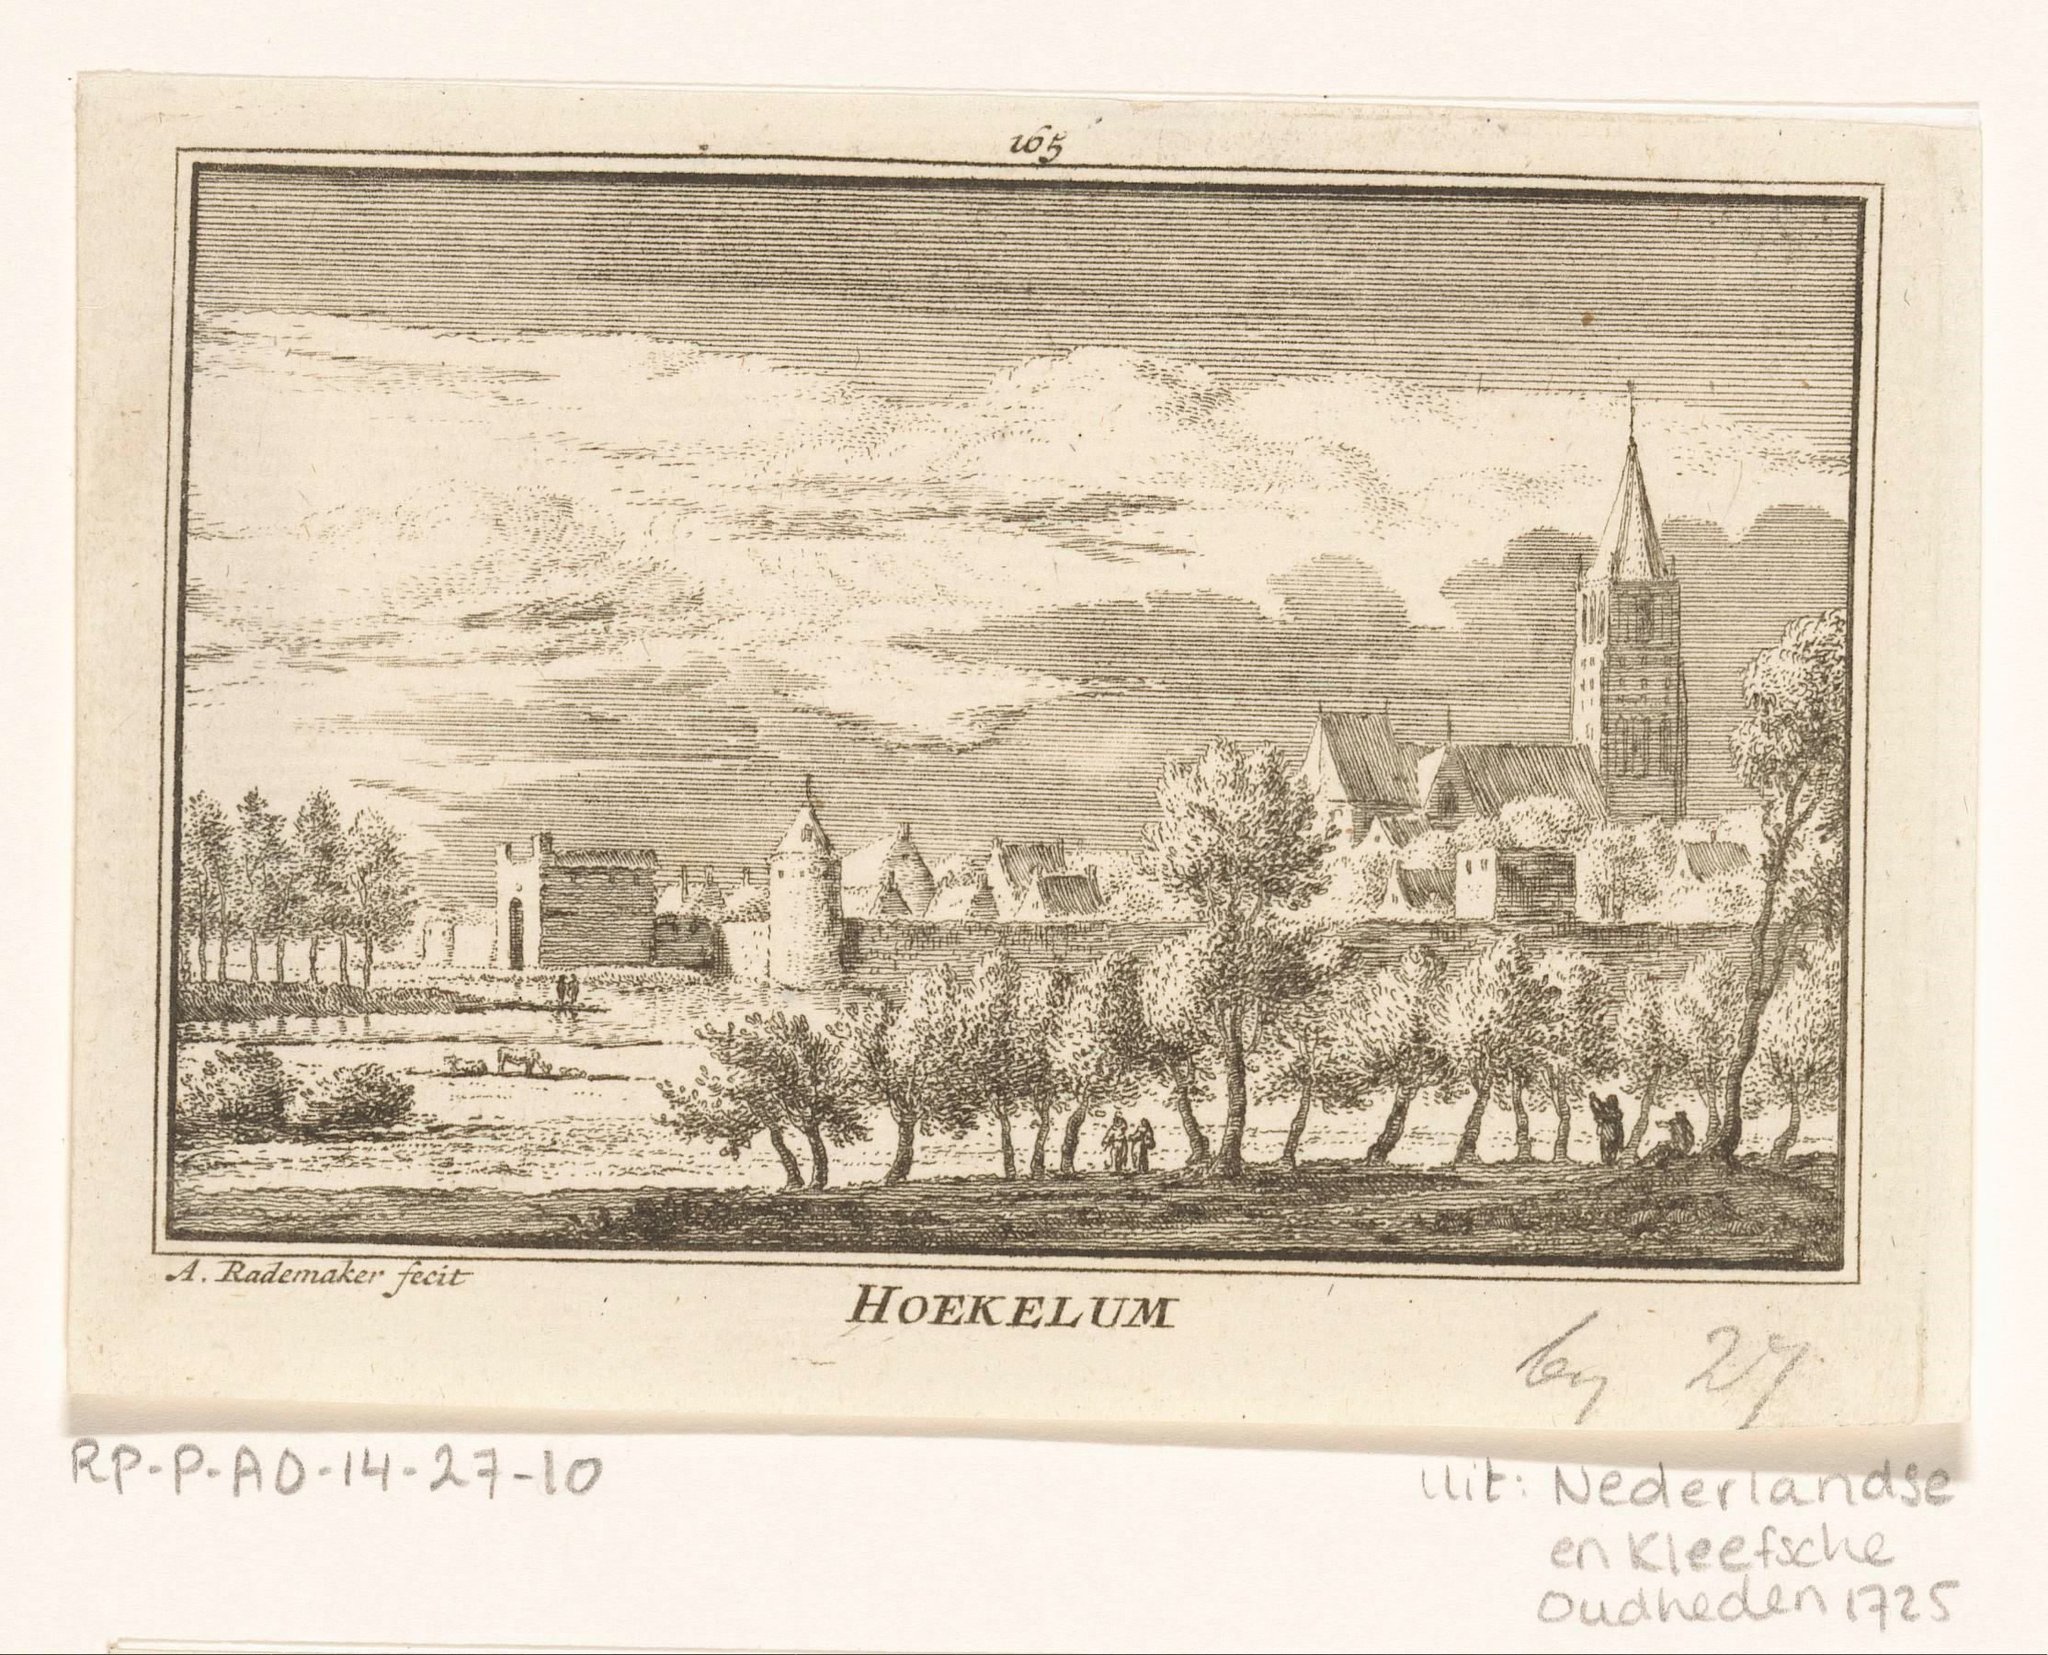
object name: book illustration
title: Gezicht op Heukelum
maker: abraham rademaker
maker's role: draughtsman, print maker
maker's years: 1676-1735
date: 1725-1803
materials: paper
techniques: engraving, etching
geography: amsterdam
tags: church (exterior), city-gate, prospect of city, town panorama, silhouette of city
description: Prent ook gebruikt in: Rademaker, Abraham. Kabinet van Nederlandsche outheden en gezichten: vervat in 300 konstplaaten (…). 2 delen. Amsterdam: Willem Barents, 1725, dl. 2, ill. 165. Na 1725 is deze prent nog in verschillende heruitgaven verschenen, uitgegeven in 1727-1733, 1770-1771 en 1792-1803. Uit welke uitgave het huidige exemplaar precies komt is niet na te gaan.